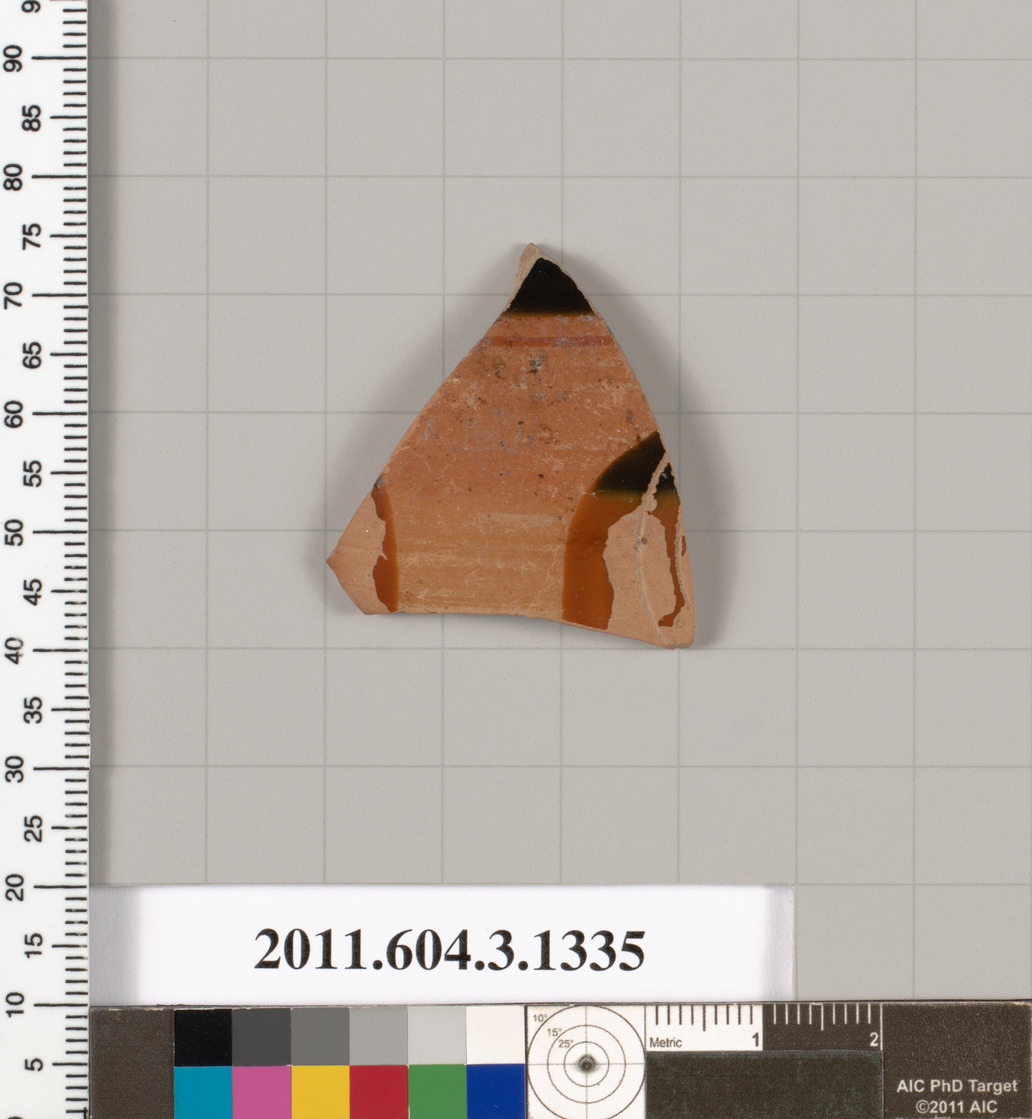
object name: skyphos fragment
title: Terracotta fragment of a skyphos (deep drinking cup)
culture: greek, attic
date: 500-468 BCE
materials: terracotta